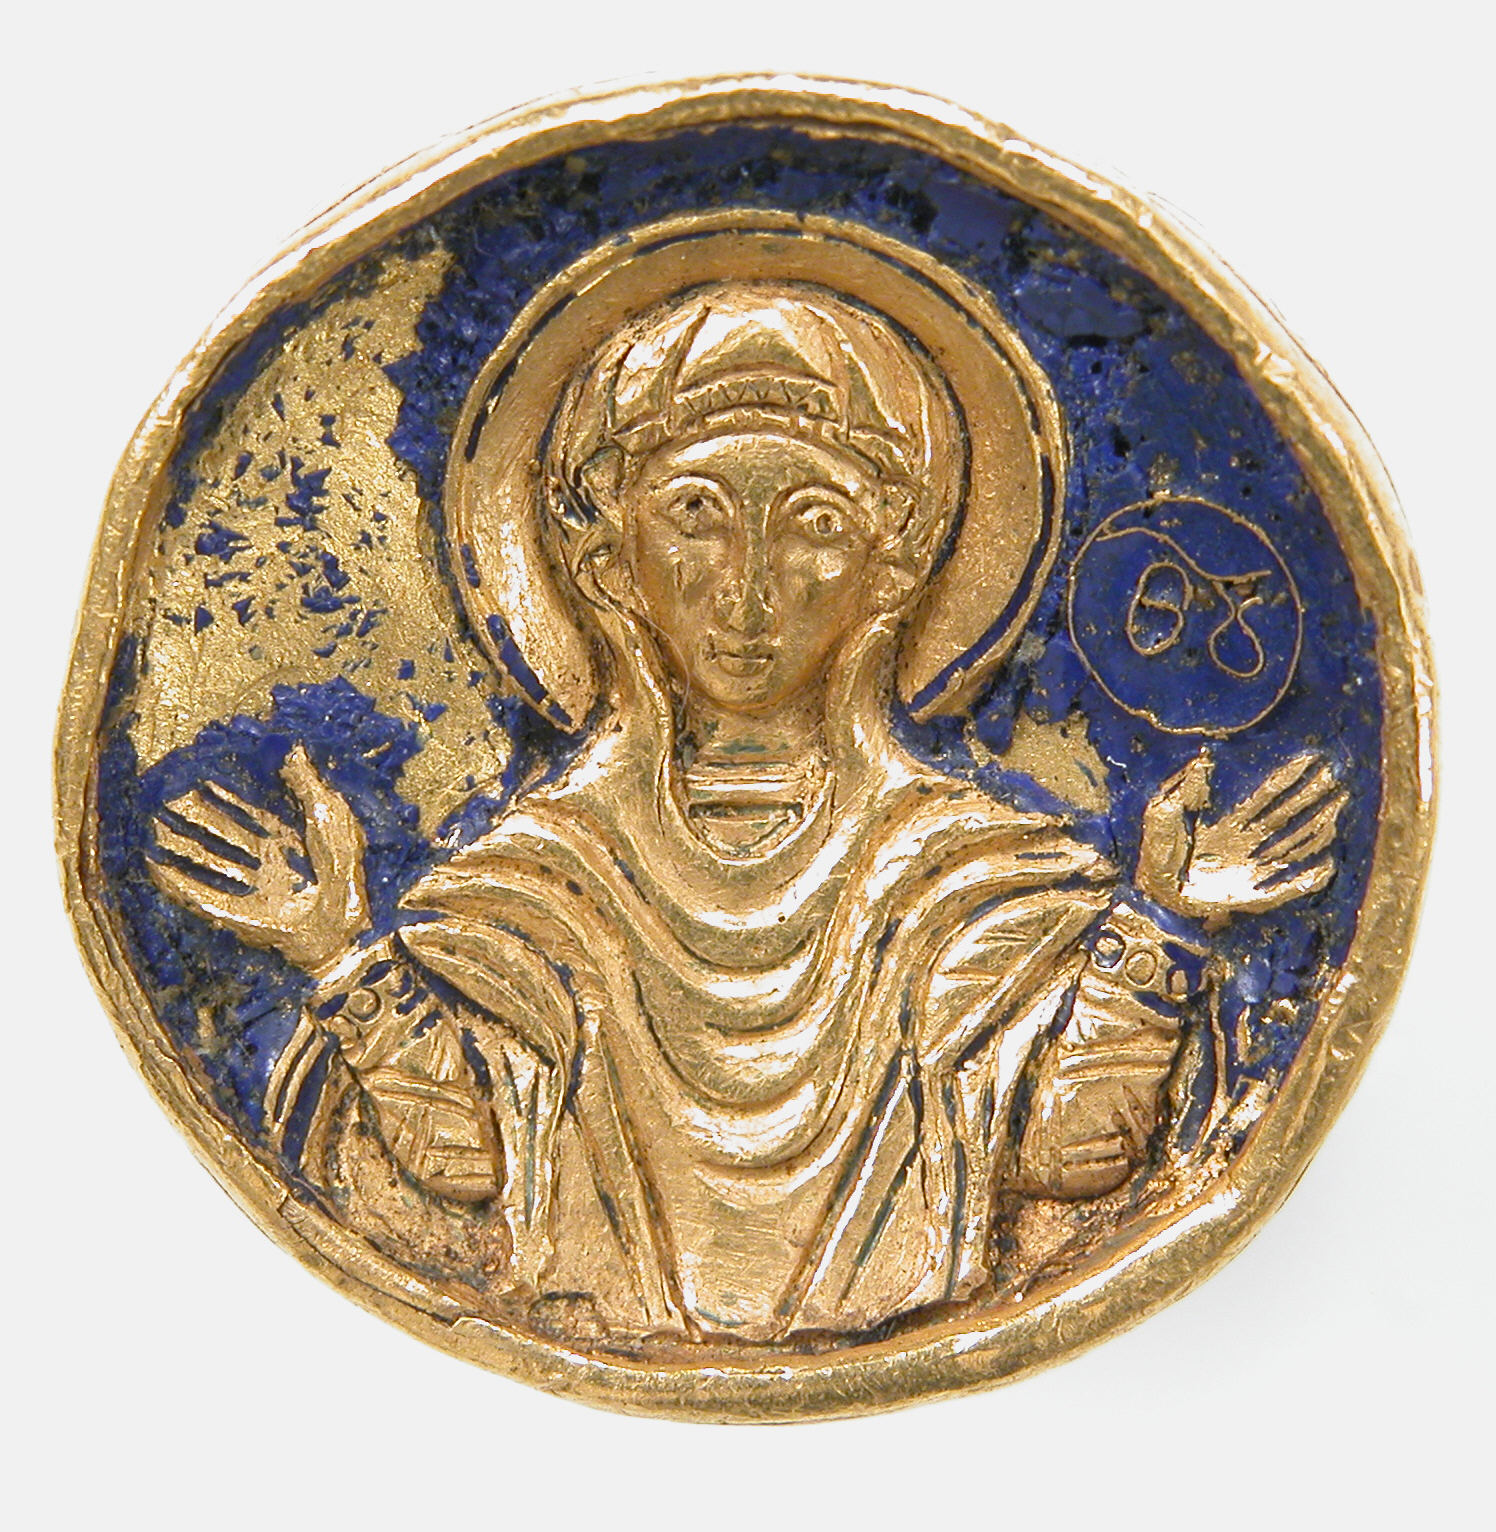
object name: ring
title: Ring with Enamel Bezel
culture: byzantine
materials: enamel, gold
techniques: painting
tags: women